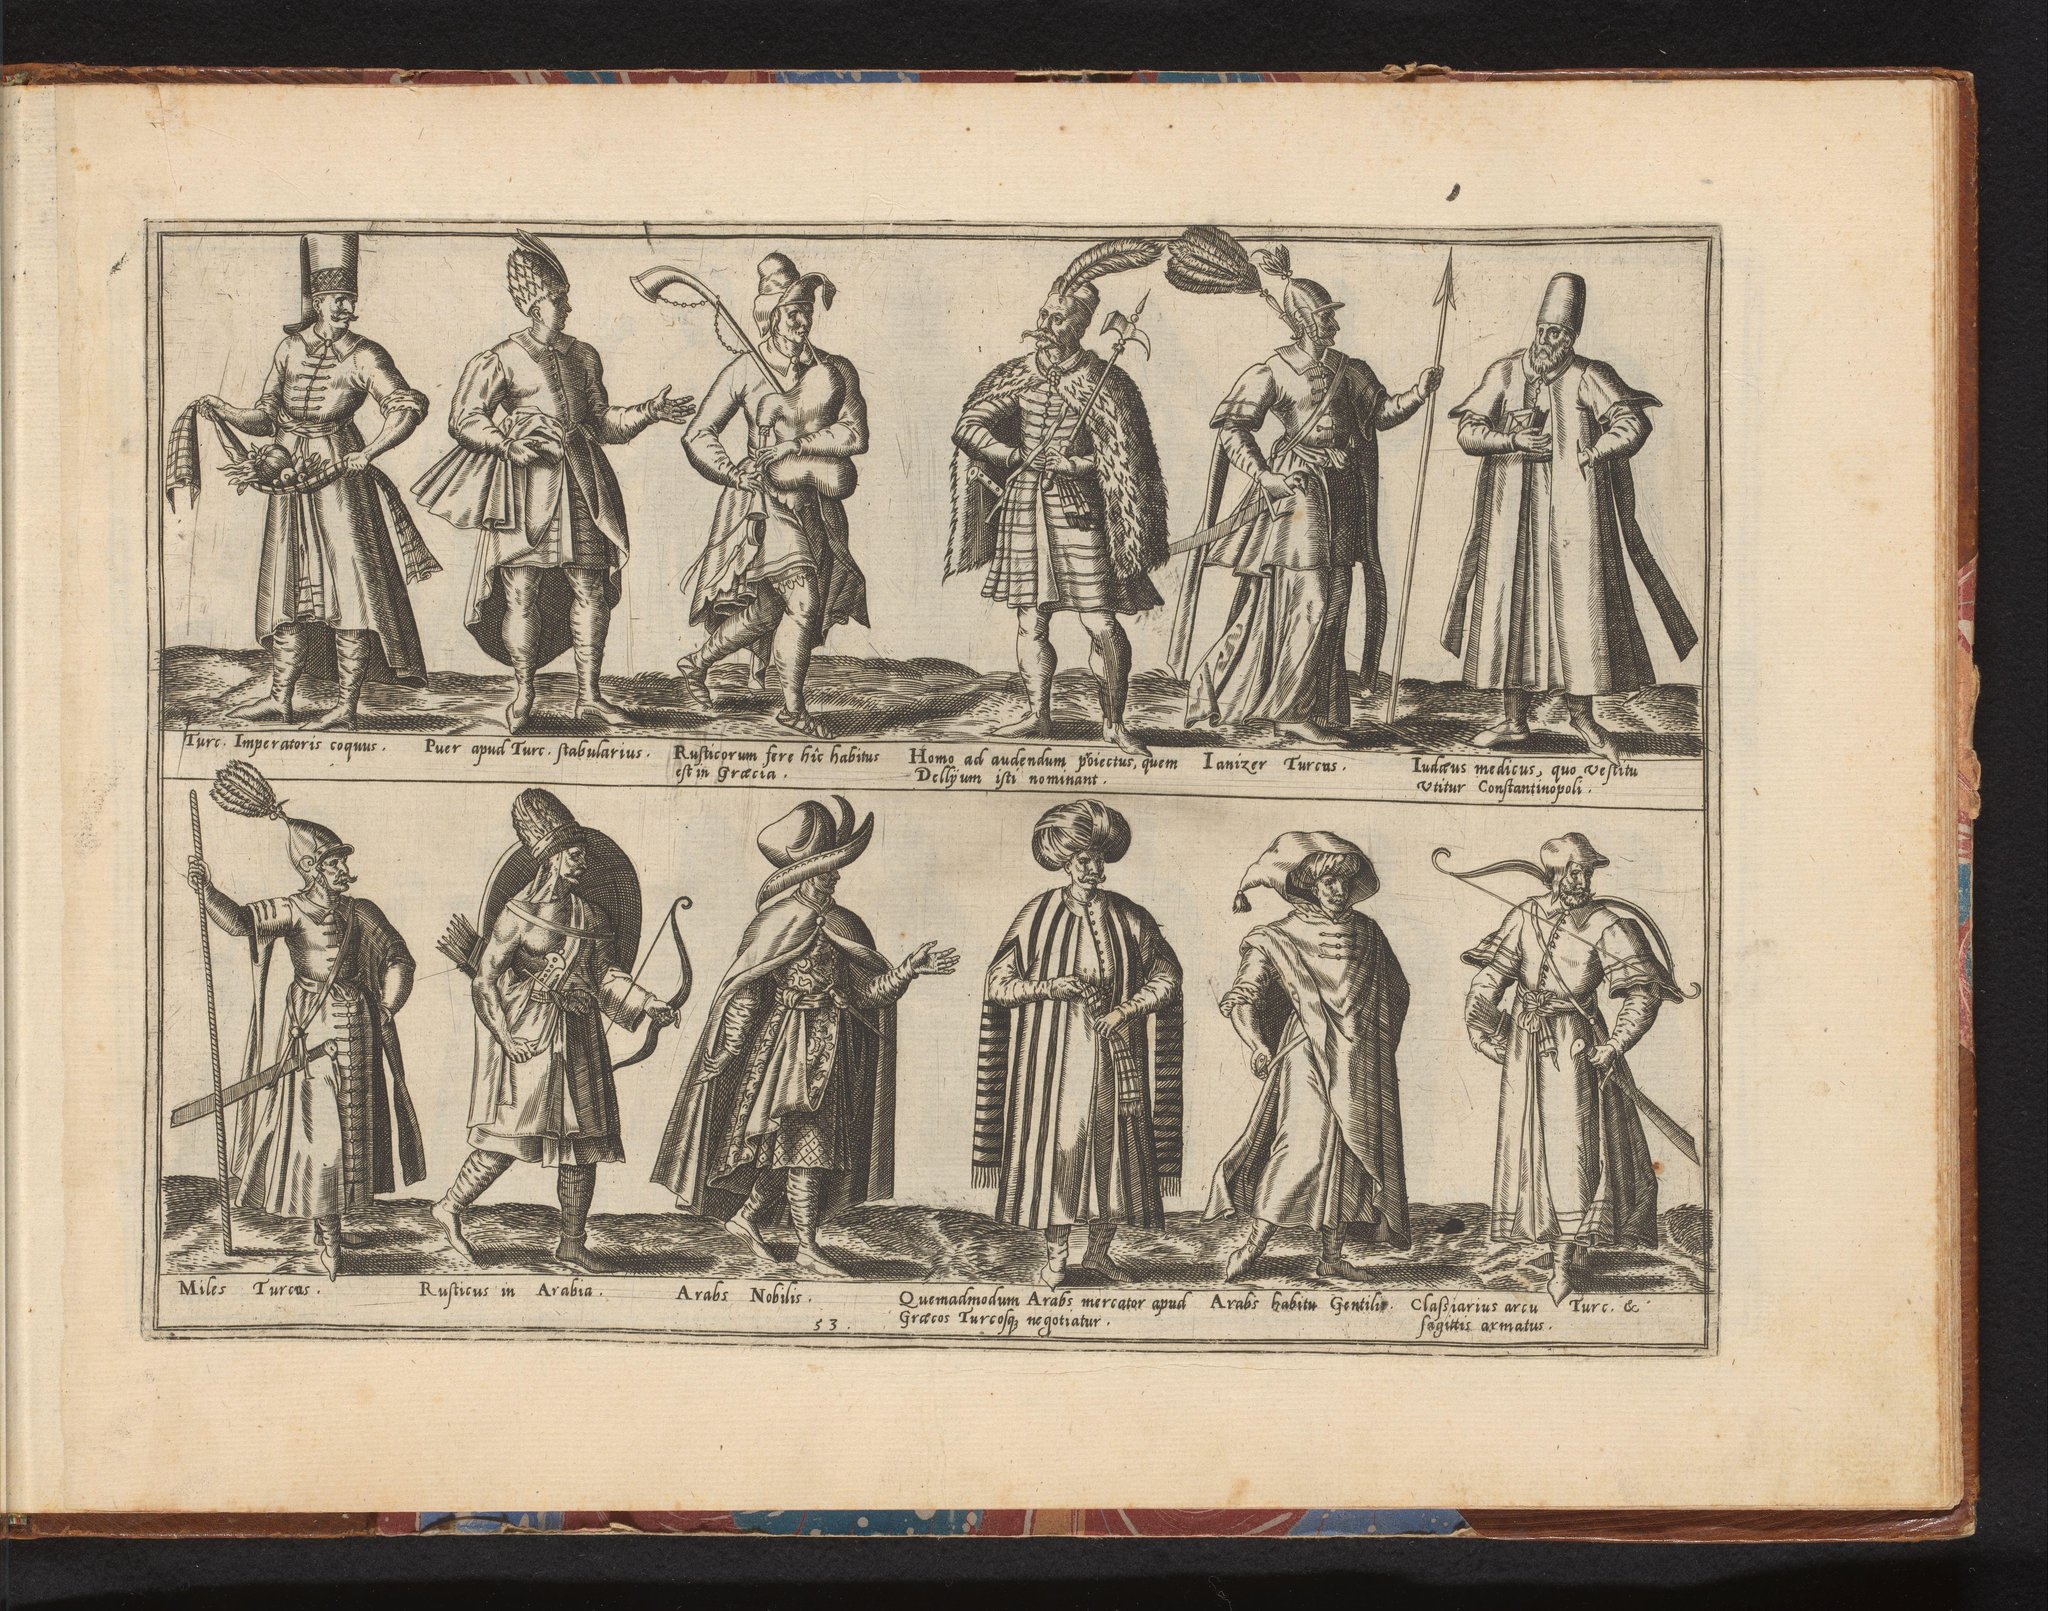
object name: costume print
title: Twaalf Arabieren, gekleed volgens de dracht van ca. 1580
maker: abraham de bruyn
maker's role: print maker, publisher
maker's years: 1540-1587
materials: paper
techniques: engraving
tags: africans (+ costume), clothes, costume (+ men's clothes)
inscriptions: number: ‘53’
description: Prent uit het boek 'Omnium pene Europae, Asiae, Aphricae atque Americae gentium habitus...', 1581. De prent maakt deel uit van een album.